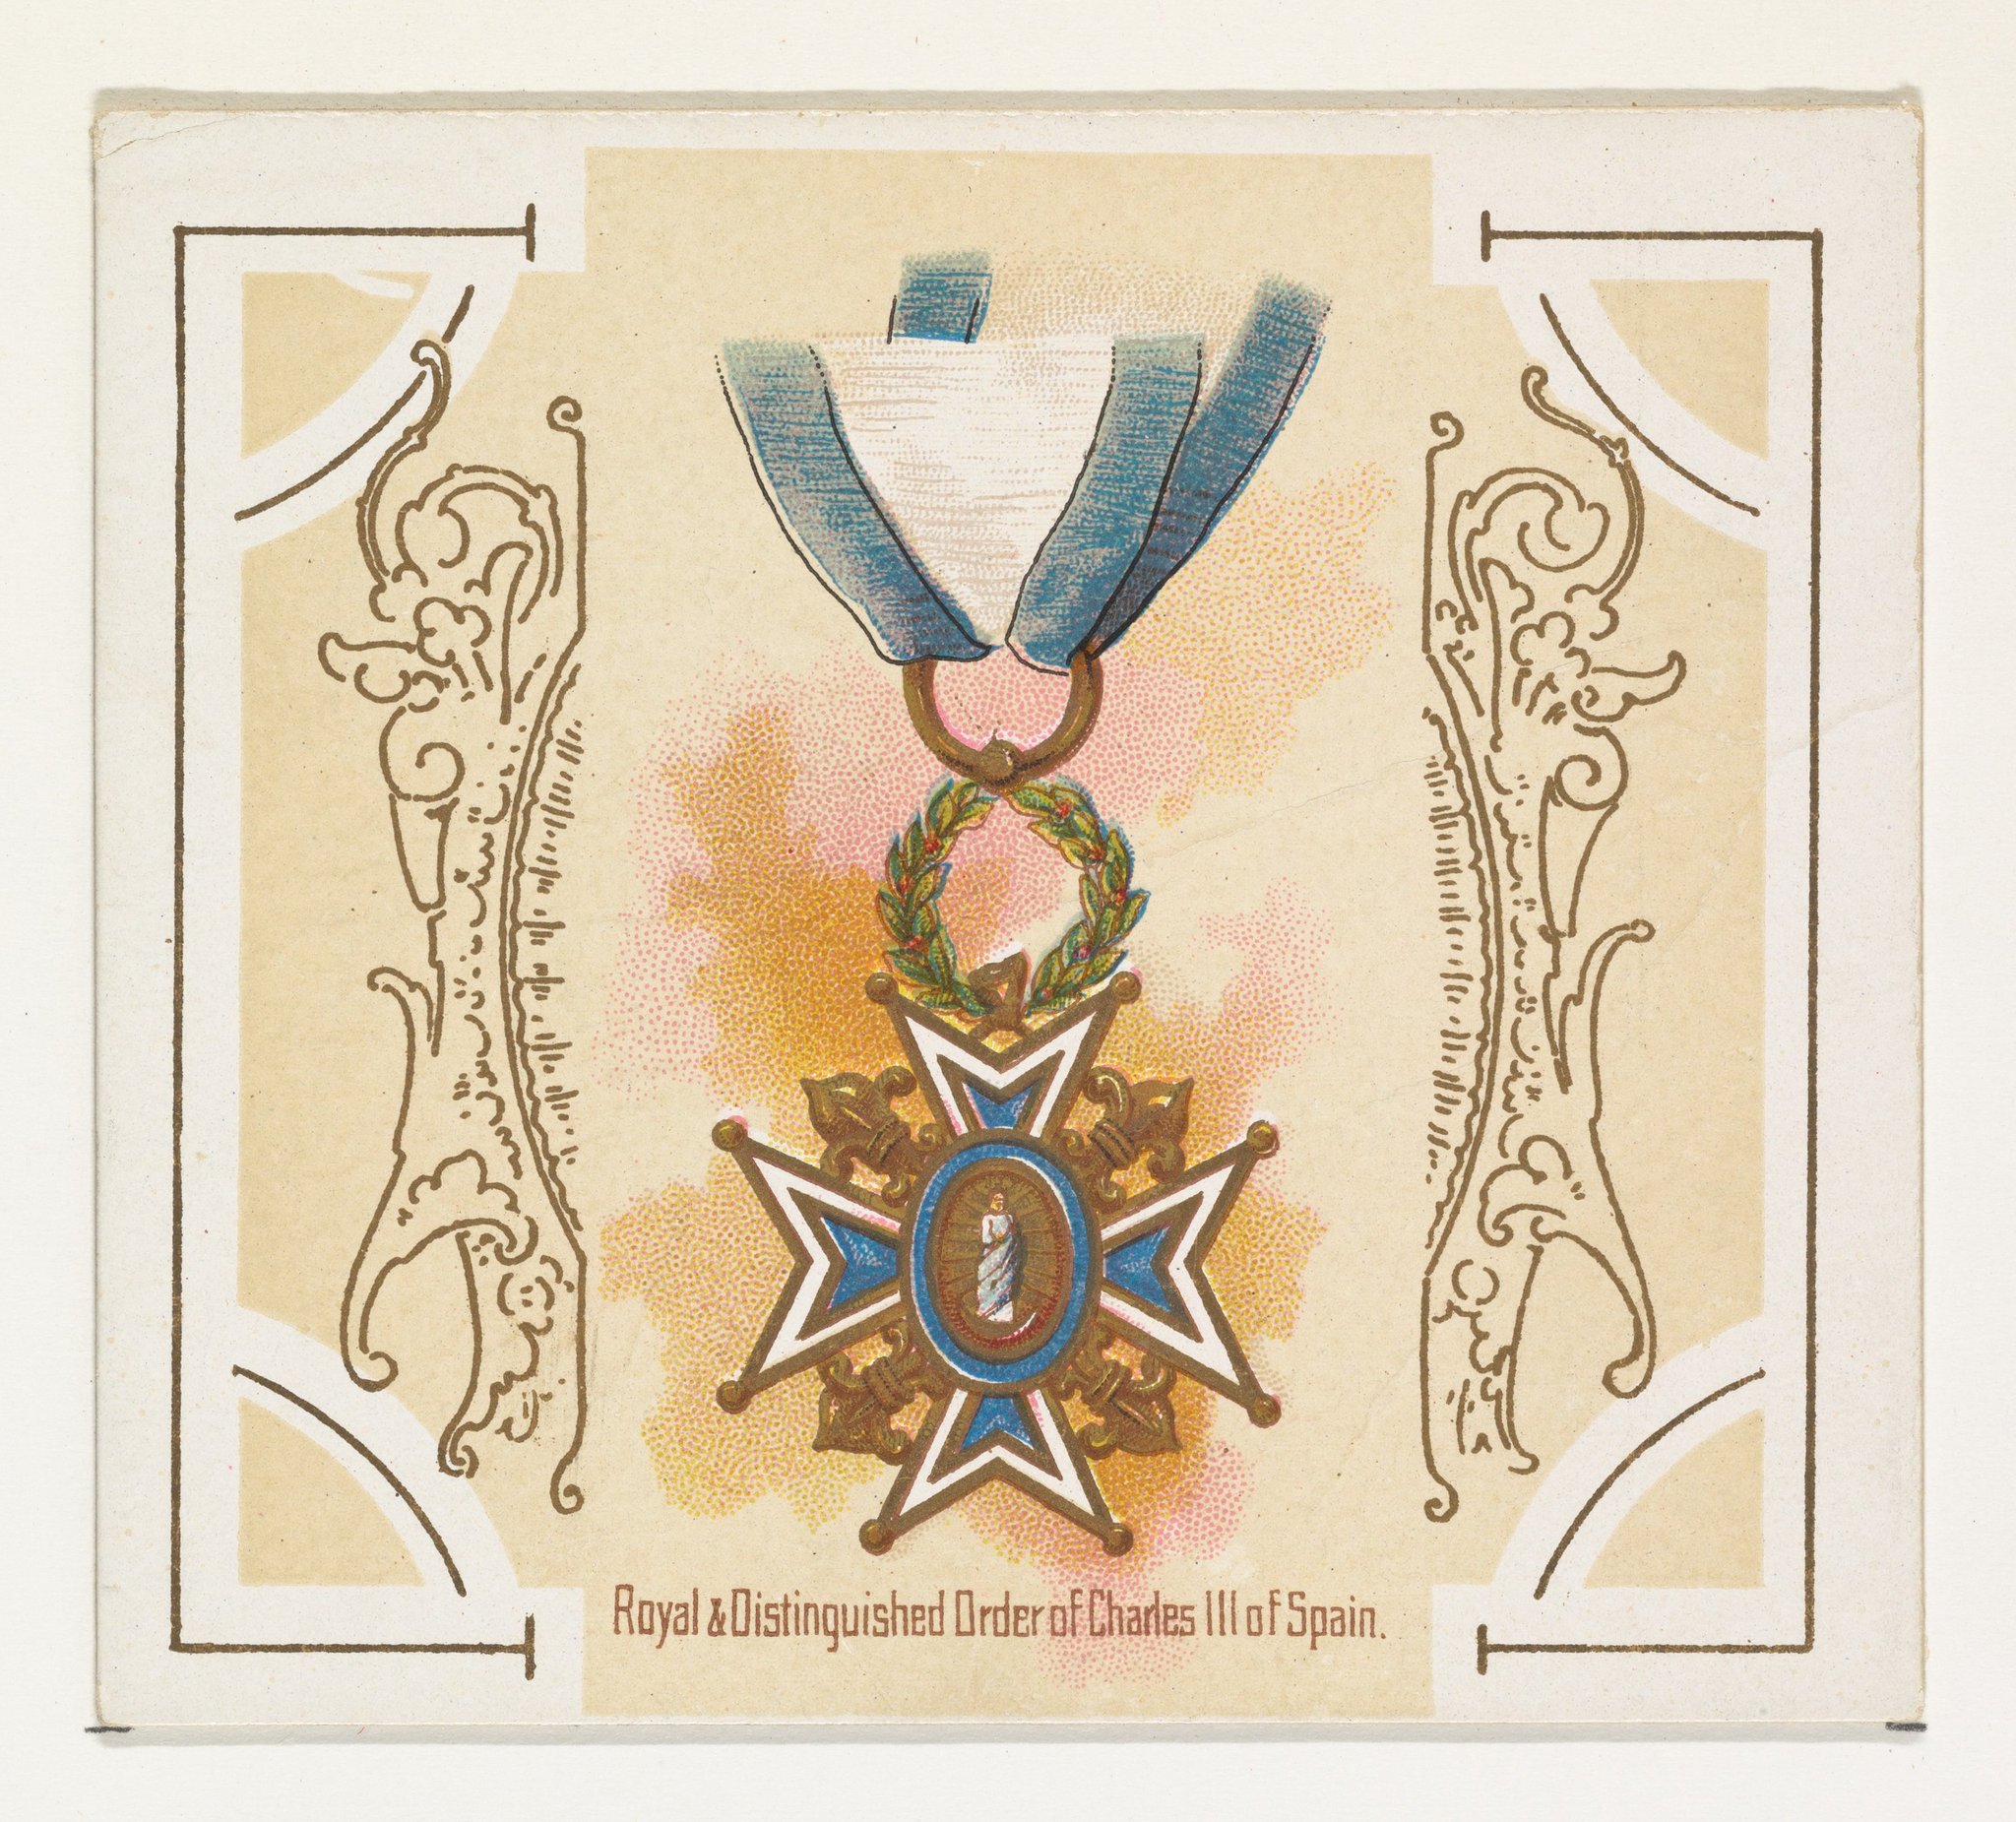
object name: print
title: Royal and Distinguished Order of Charles III of Spain, from the World's Decorations series (N44) for Allen & Ginter Cigarettes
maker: allen & ginter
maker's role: publisher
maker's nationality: american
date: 1890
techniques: color lithograph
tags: medals